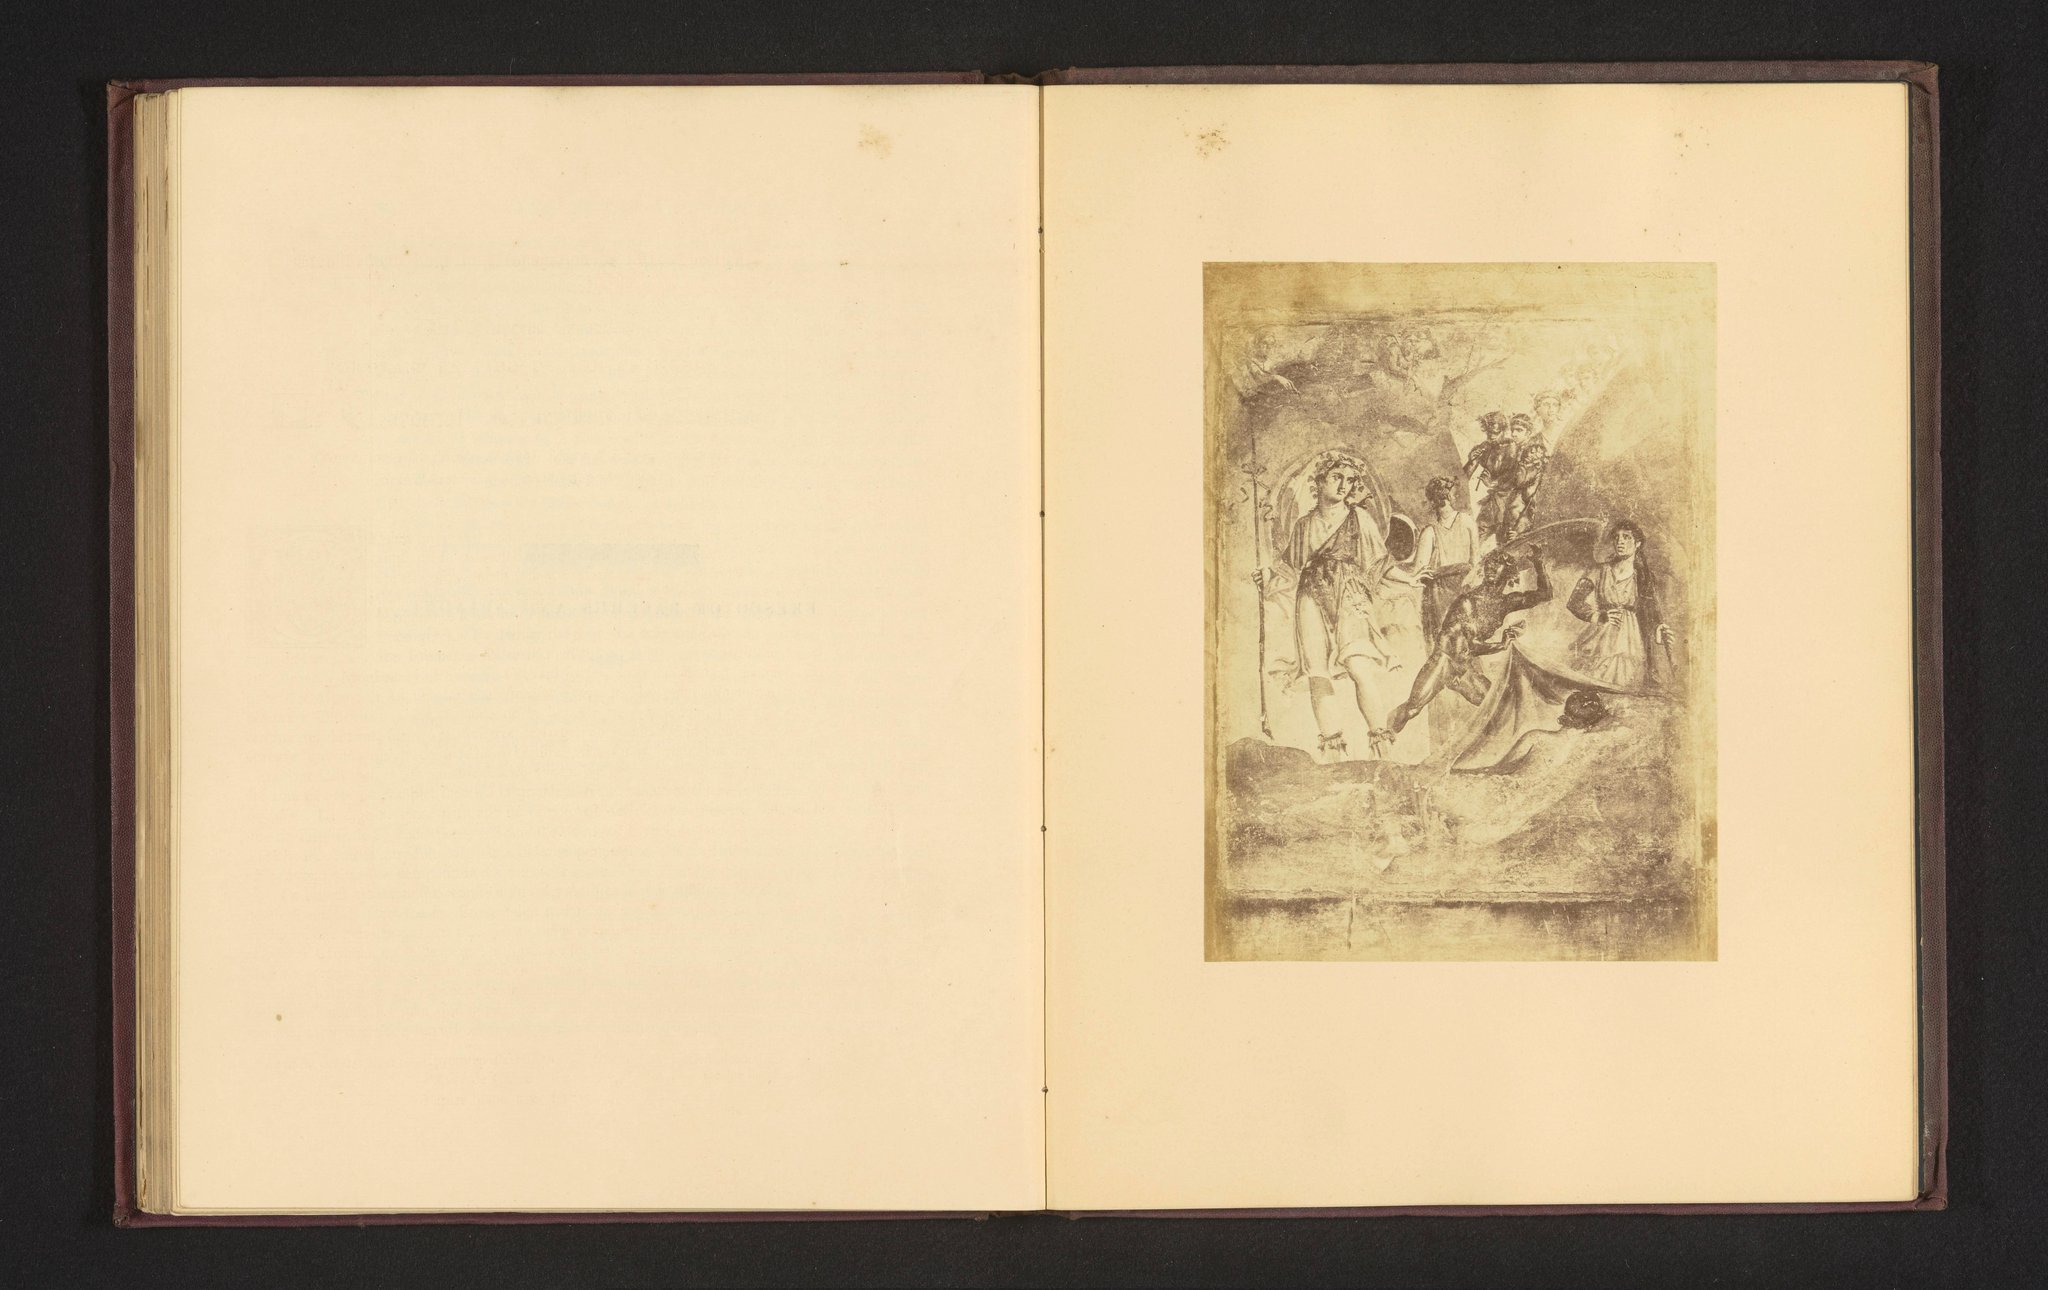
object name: page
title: Gezicht op een fresco met een afbeelding van Bacchus en Ariadne te Pompeï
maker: Anonymous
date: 1862-1867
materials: cardboard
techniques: albumen print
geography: pompeii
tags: (story of) ariadne and bacchus, painting, drawing and the graphic arts, pompeii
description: Foto op derde ongenummerde pagina na pagina 80.